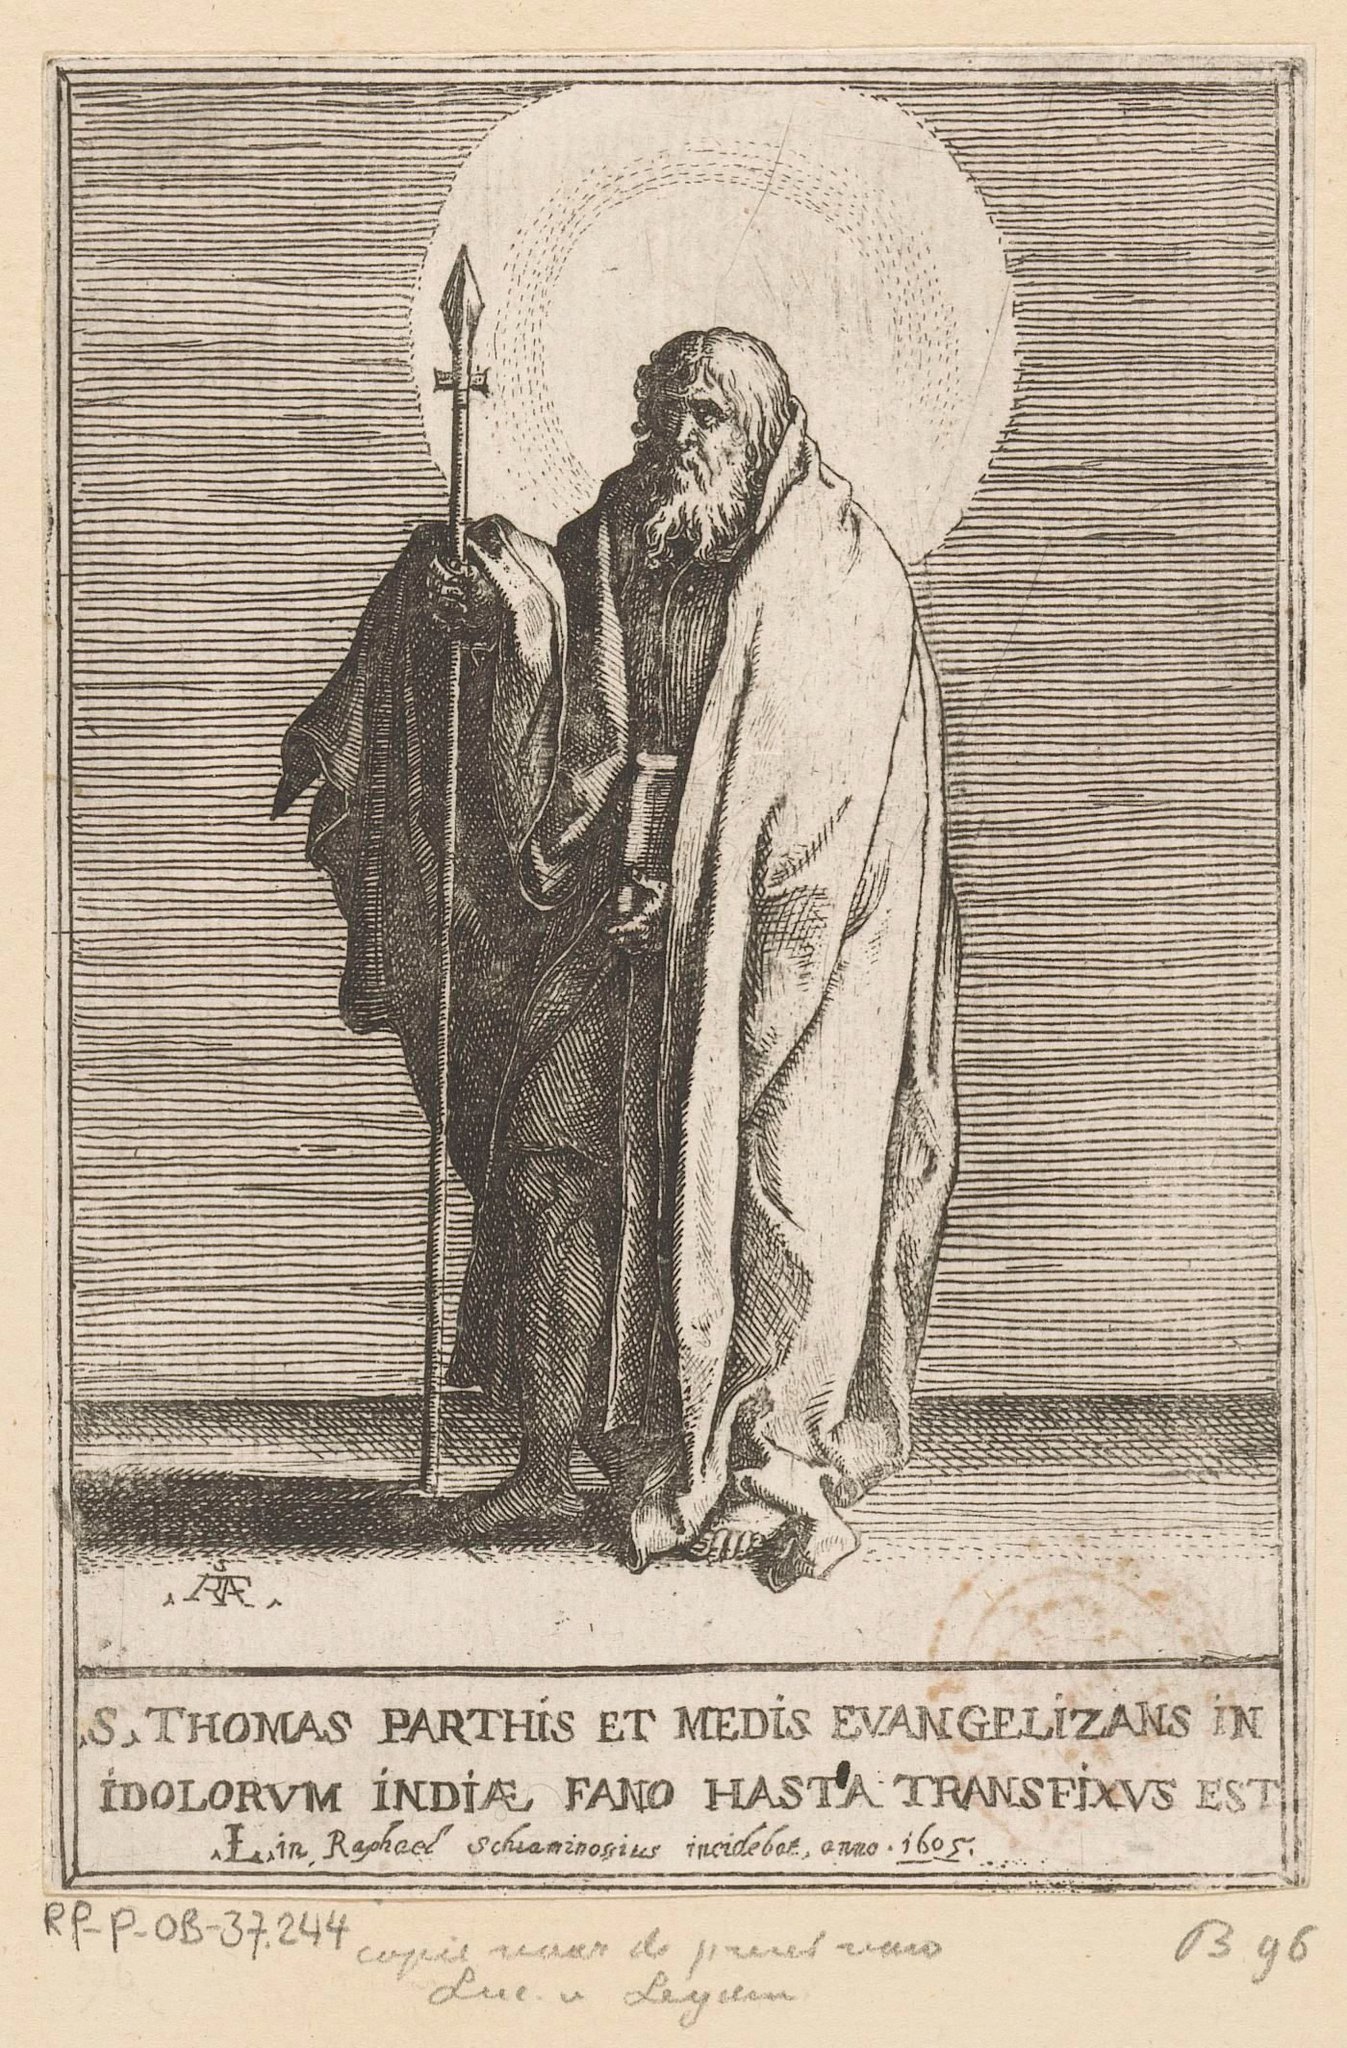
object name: print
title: Heilige Tomas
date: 1605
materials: paper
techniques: etching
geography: italy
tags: the apostle thomas; possible attributes: book, chalice, girdle, heart, lance or spear, scroll, square, stones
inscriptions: collector's mark: Lugt 240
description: Spiegelbeeldige kopie naar een prent van Lucas van Leyden.